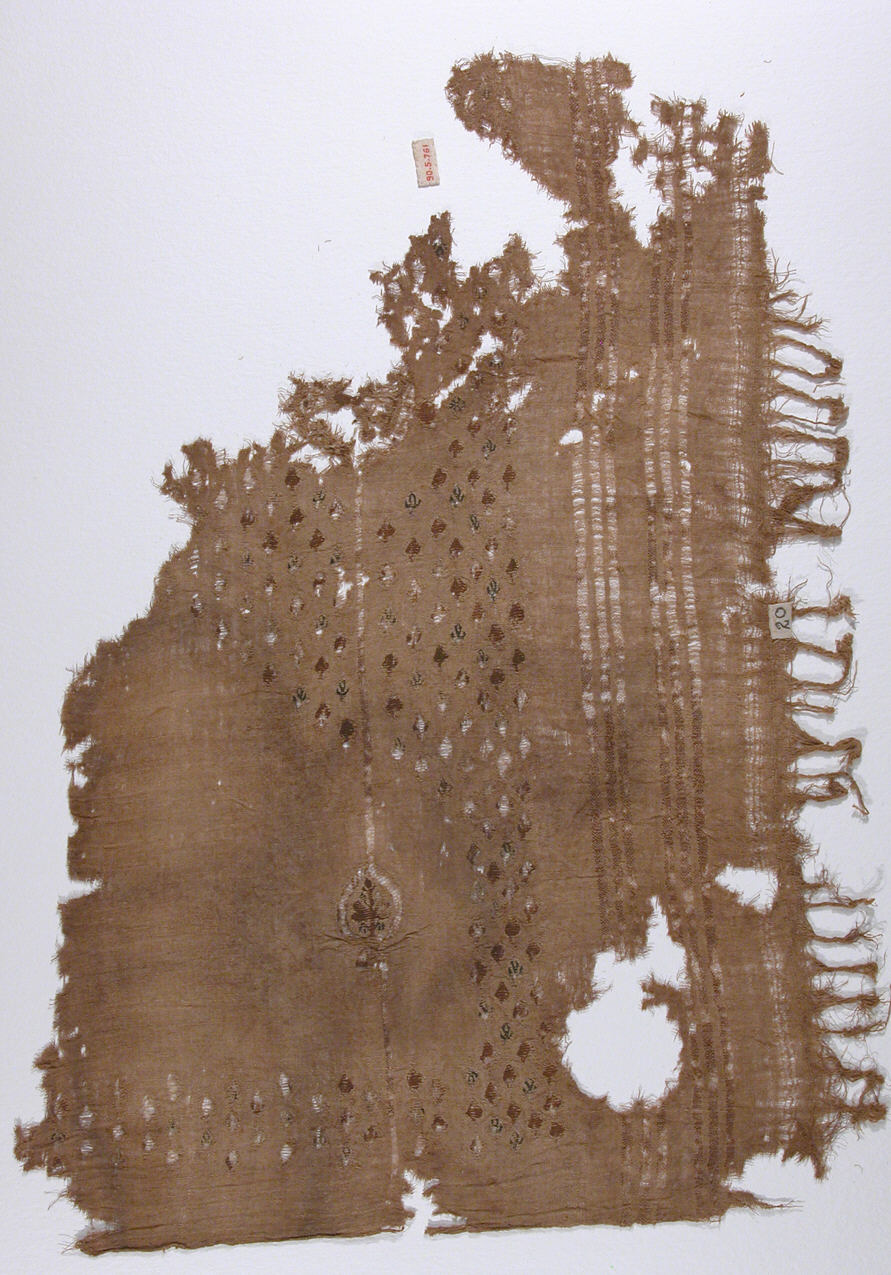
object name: textile fragment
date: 401-500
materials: linen, wool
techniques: weave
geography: egypt